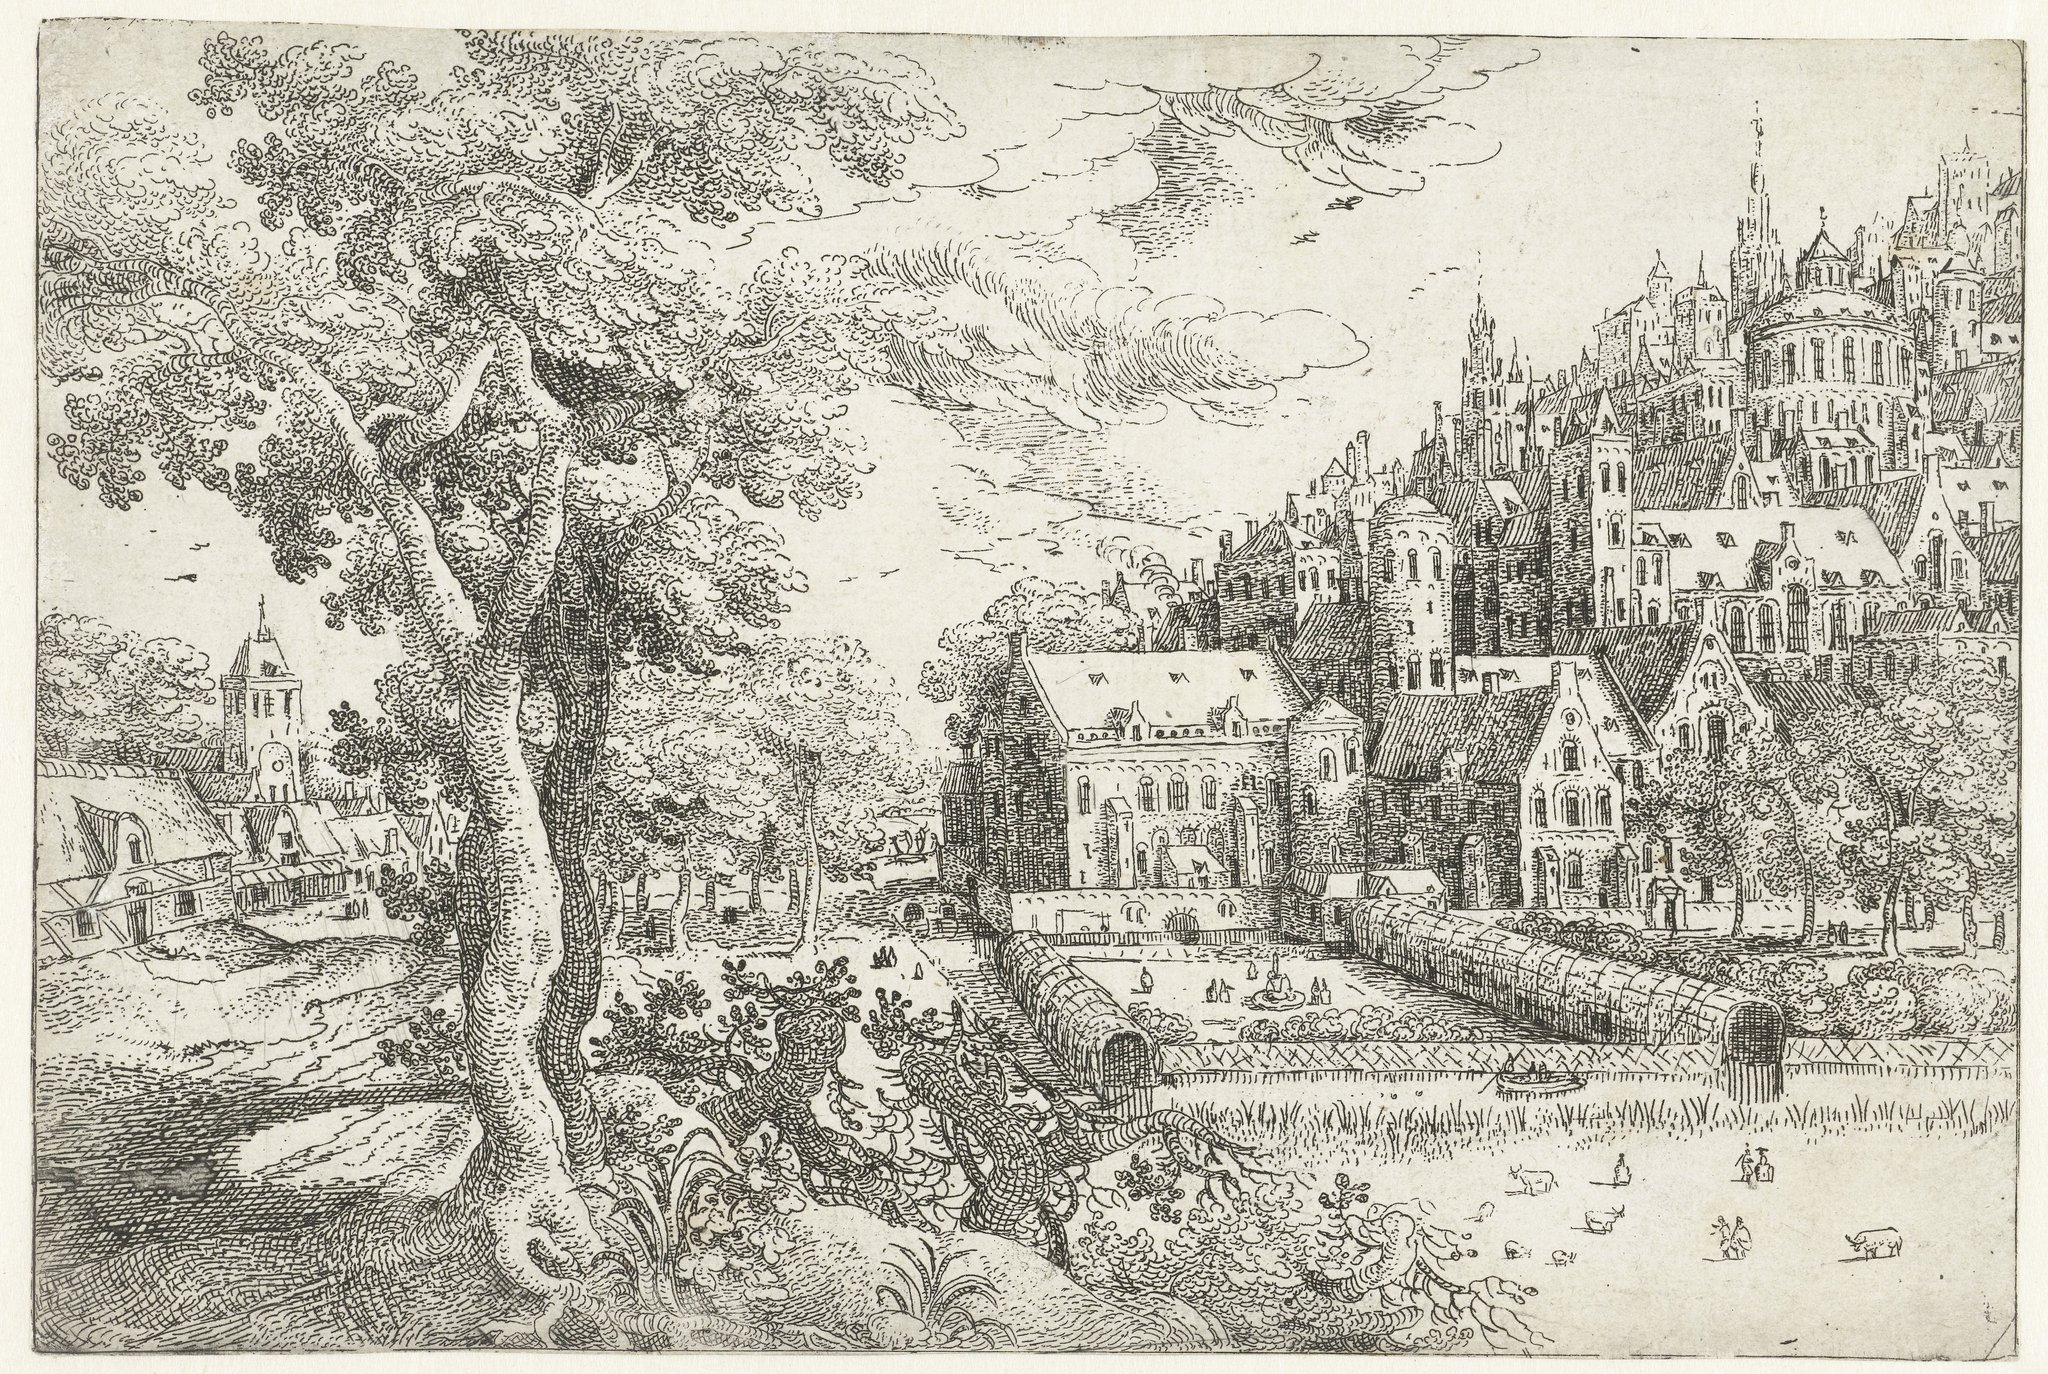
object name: print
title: Landschap met stad tegen een heuvel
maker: Anonymous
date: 1550-1580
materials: paper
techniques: etching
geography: southern netherlands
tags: city-view, and landscape with man-made constructions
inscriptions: collector's mark: Lugt 2760, collector's mark: Lugt 2228a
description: Landschap met rechts een stad tegen de heuvel aan gebouwd. Kasteeltuin met pergola's en gracht eromheen op de voorgrond. Links enkele bomen; op het tweede plan links lage huisjes en een kerk.